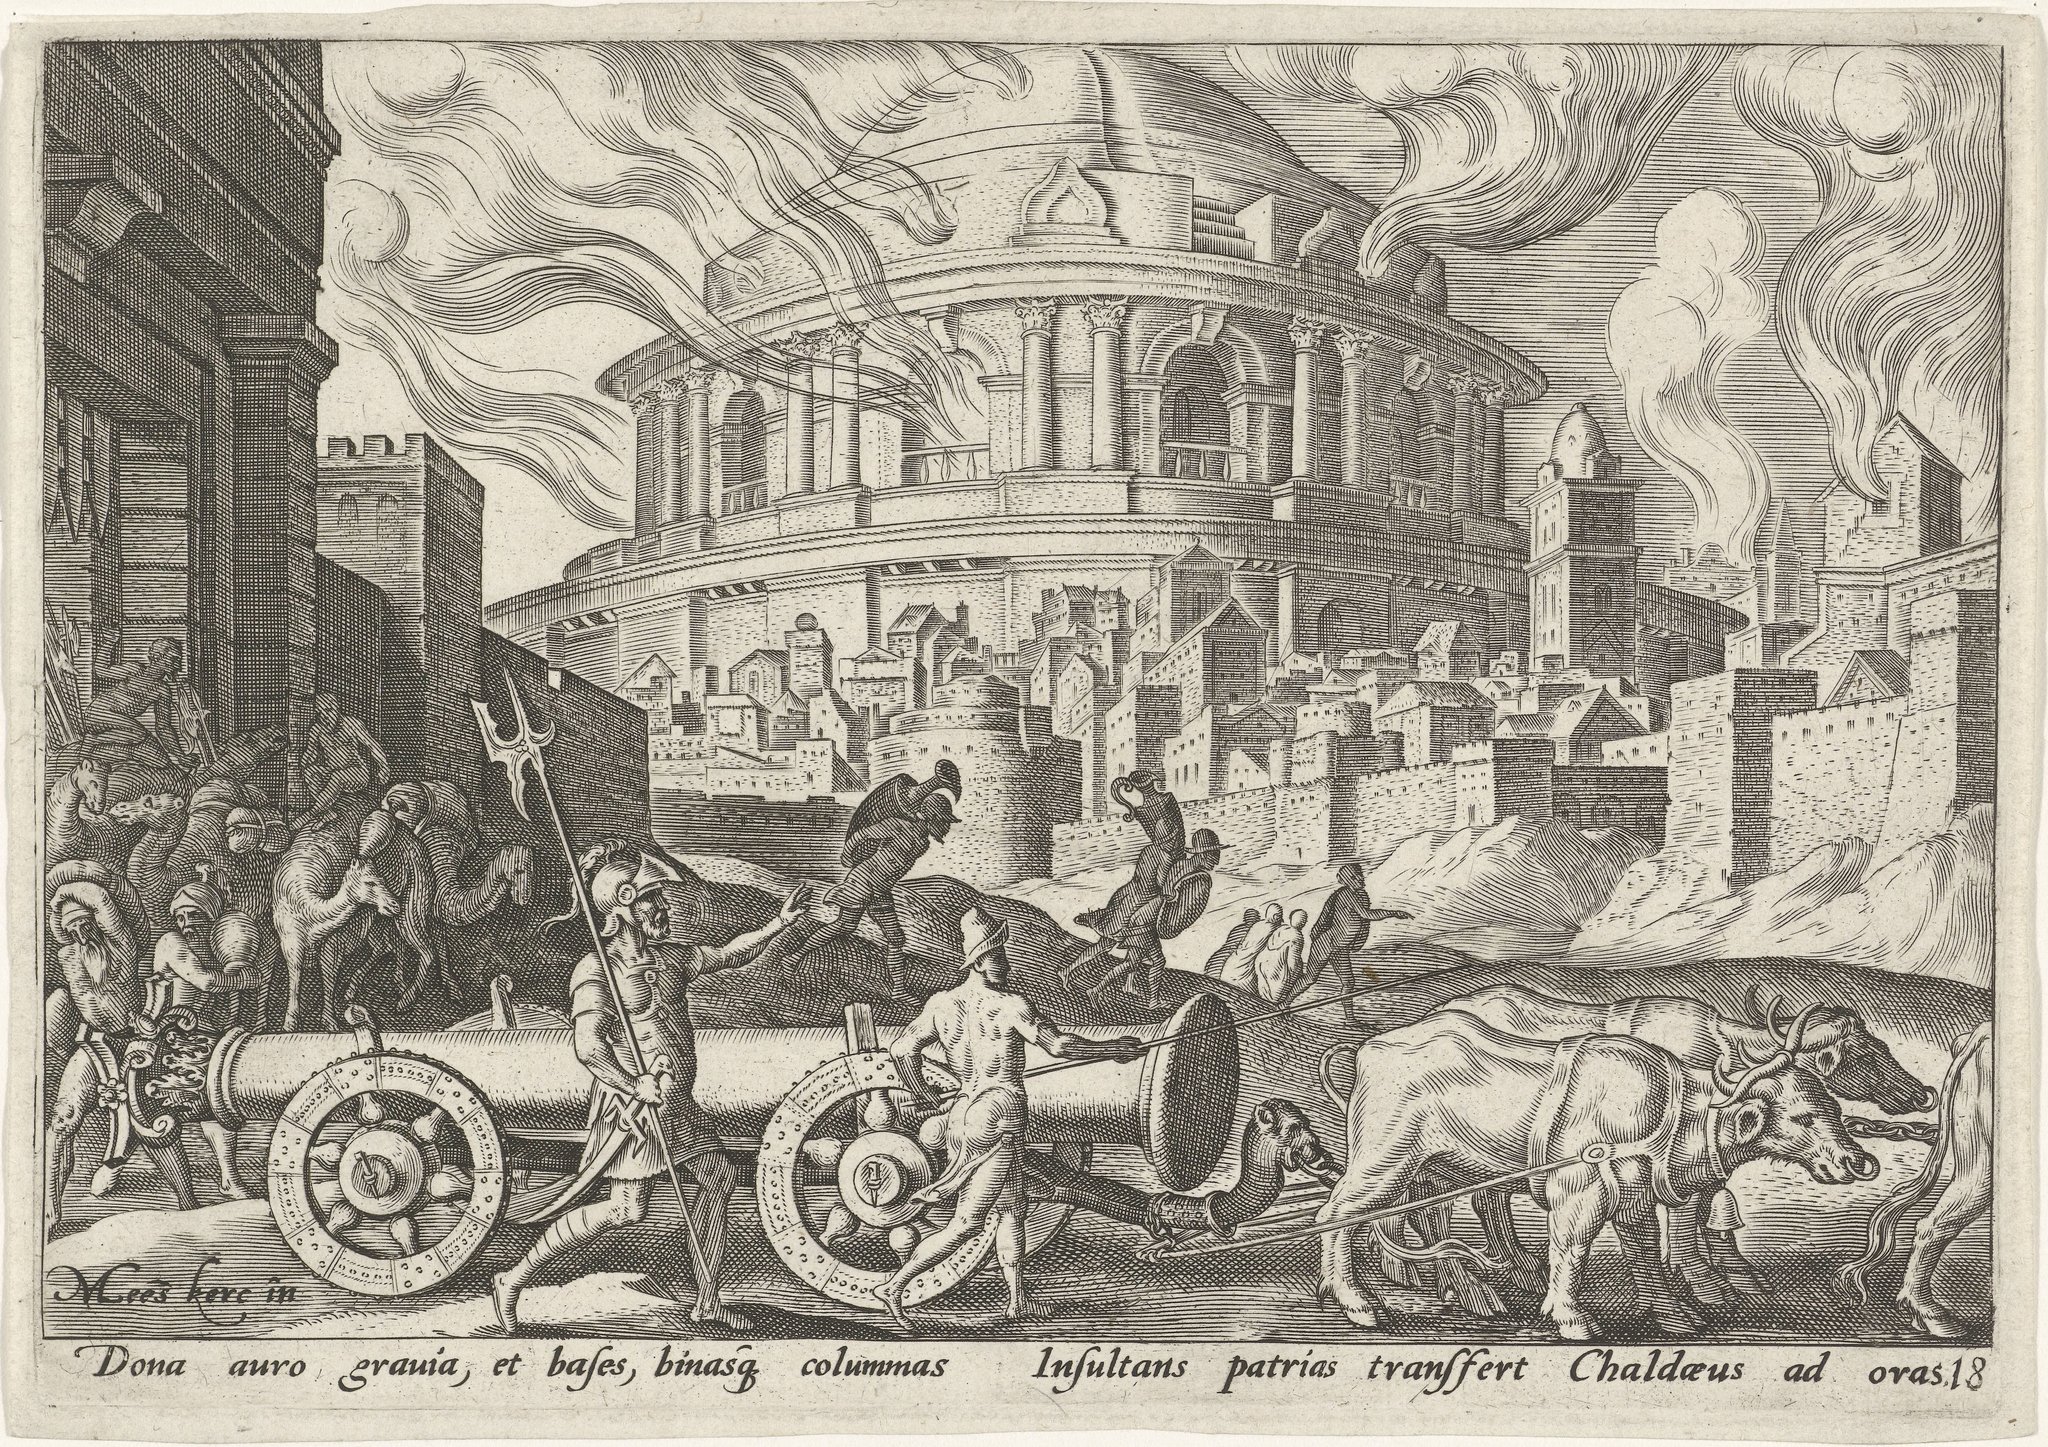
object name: print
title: De onheilsdagen van het Joodse volk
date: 1569-1650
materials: paper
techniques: engraving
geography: haarlem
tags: nebuzaradan, commander of the babylonian army, burns down the temple and the palace of jerusalem ~ second siege of jerusalem, the temple of jerusalem is looted ~ story of zedekiah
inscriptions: signature: ‘MHee[m]s kerc in’, caption: ‘Dona auro gravia et bases, binasq[ue] columnas...Chaldaeus ad oras’, number: ‘17’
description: Op de achtergrond een brandende tempel. Op de voorgrond mannen met vazen op hun rug en bepakte kamelen. Een zuil wordt weggevoerd op een kar, getrokken door ossen. Prent 18 uit een reeks van 21 prenten en een titelprent.